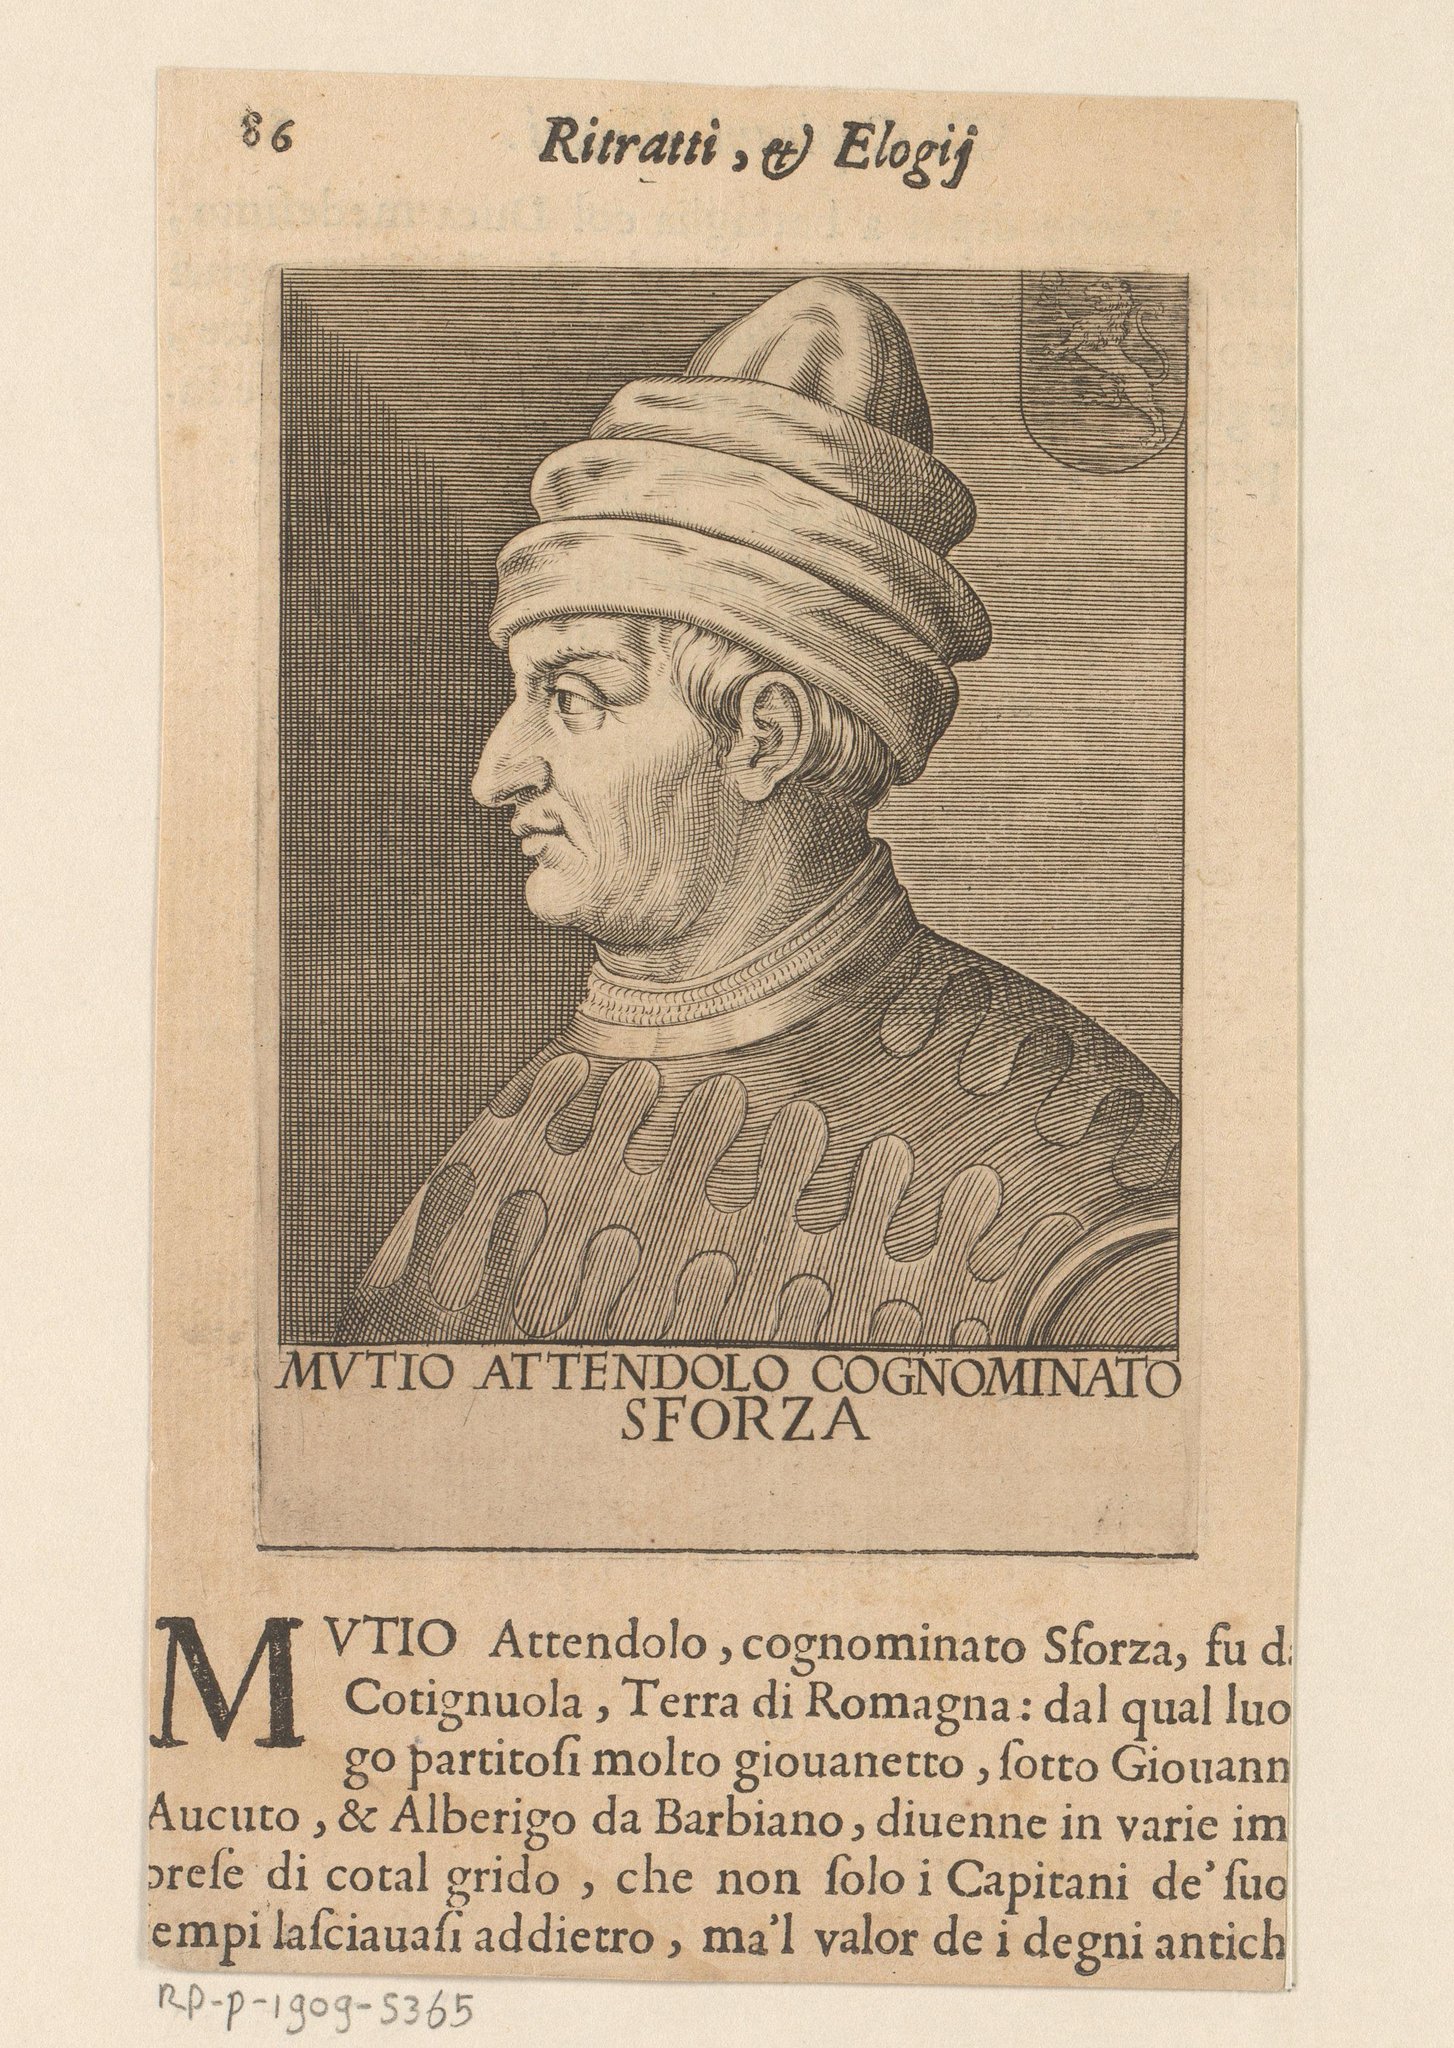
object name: book illustration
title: Mutio Attendolo cognominato Sforza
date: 1646-1647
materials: paper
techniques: engraving, letterpress printing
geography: rome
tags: commander-in-chief, general, marshal, historical persons, armorial bearing, heraldry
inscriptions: collector's mark: Lugt 2228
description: Prent uit: Ritratti et elogii di capitani Illustri. Che ne'secoli moderni hanno gloriosamente guerreggiato. Rome: Filippo de'Rossi en Vitale Mascardi, 1646, p. 86. Prent ook gebruikt in dezelfde editie van 1647. Eerdere staten van prent in ieder geval gebruikt in: Ritratti et elogii di capitani Illustri. Rome: Pompilio Totti en Andrea Fei, 1635. En in: Ritratti di cento capitani illustri con li lor Fatti in guerra (…), Rome: Domenico Gigliotti, 1596.